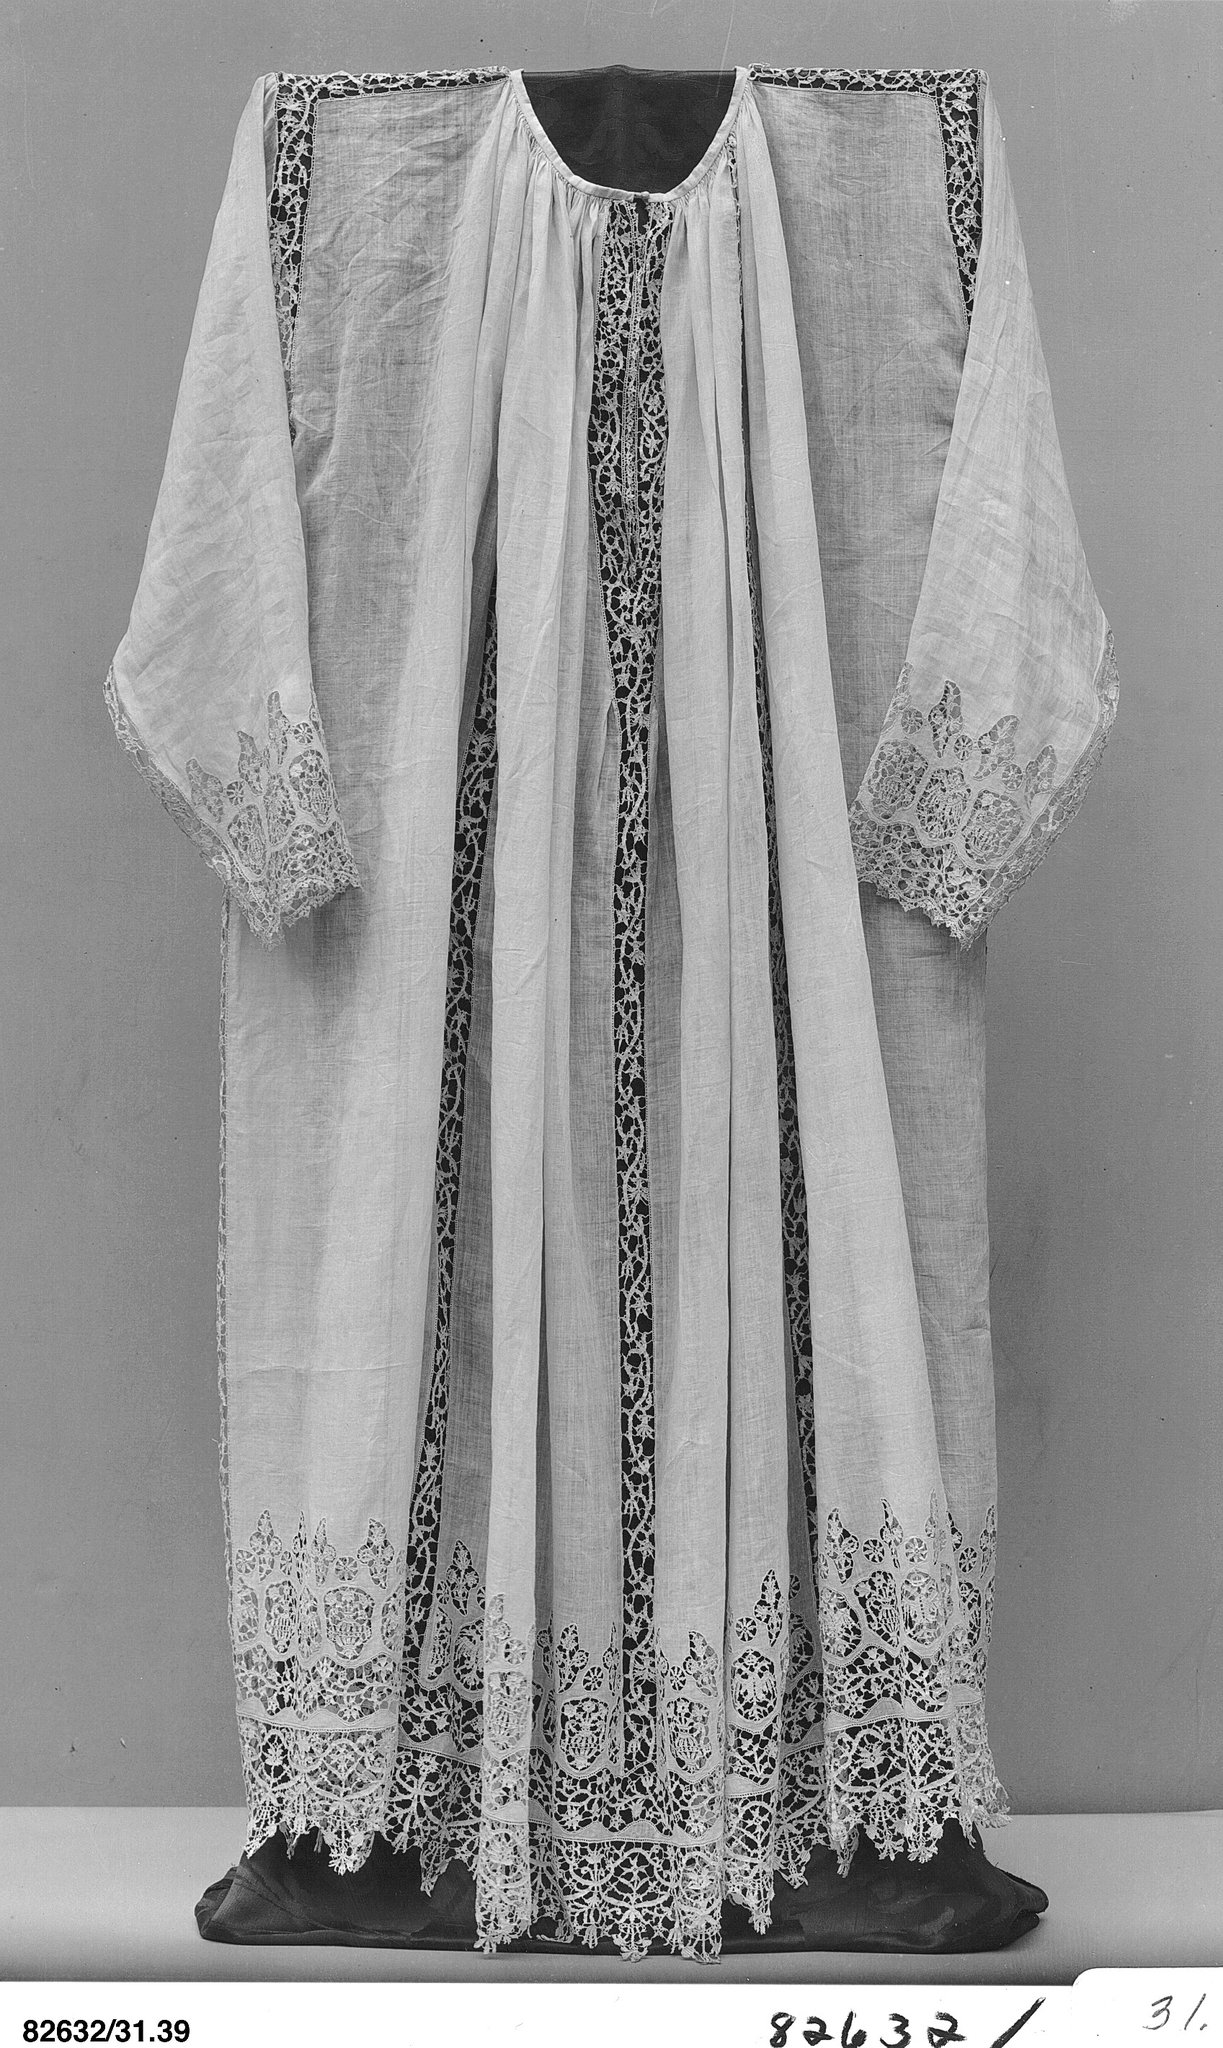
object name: alb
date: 1601-1633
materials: linen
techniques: lace